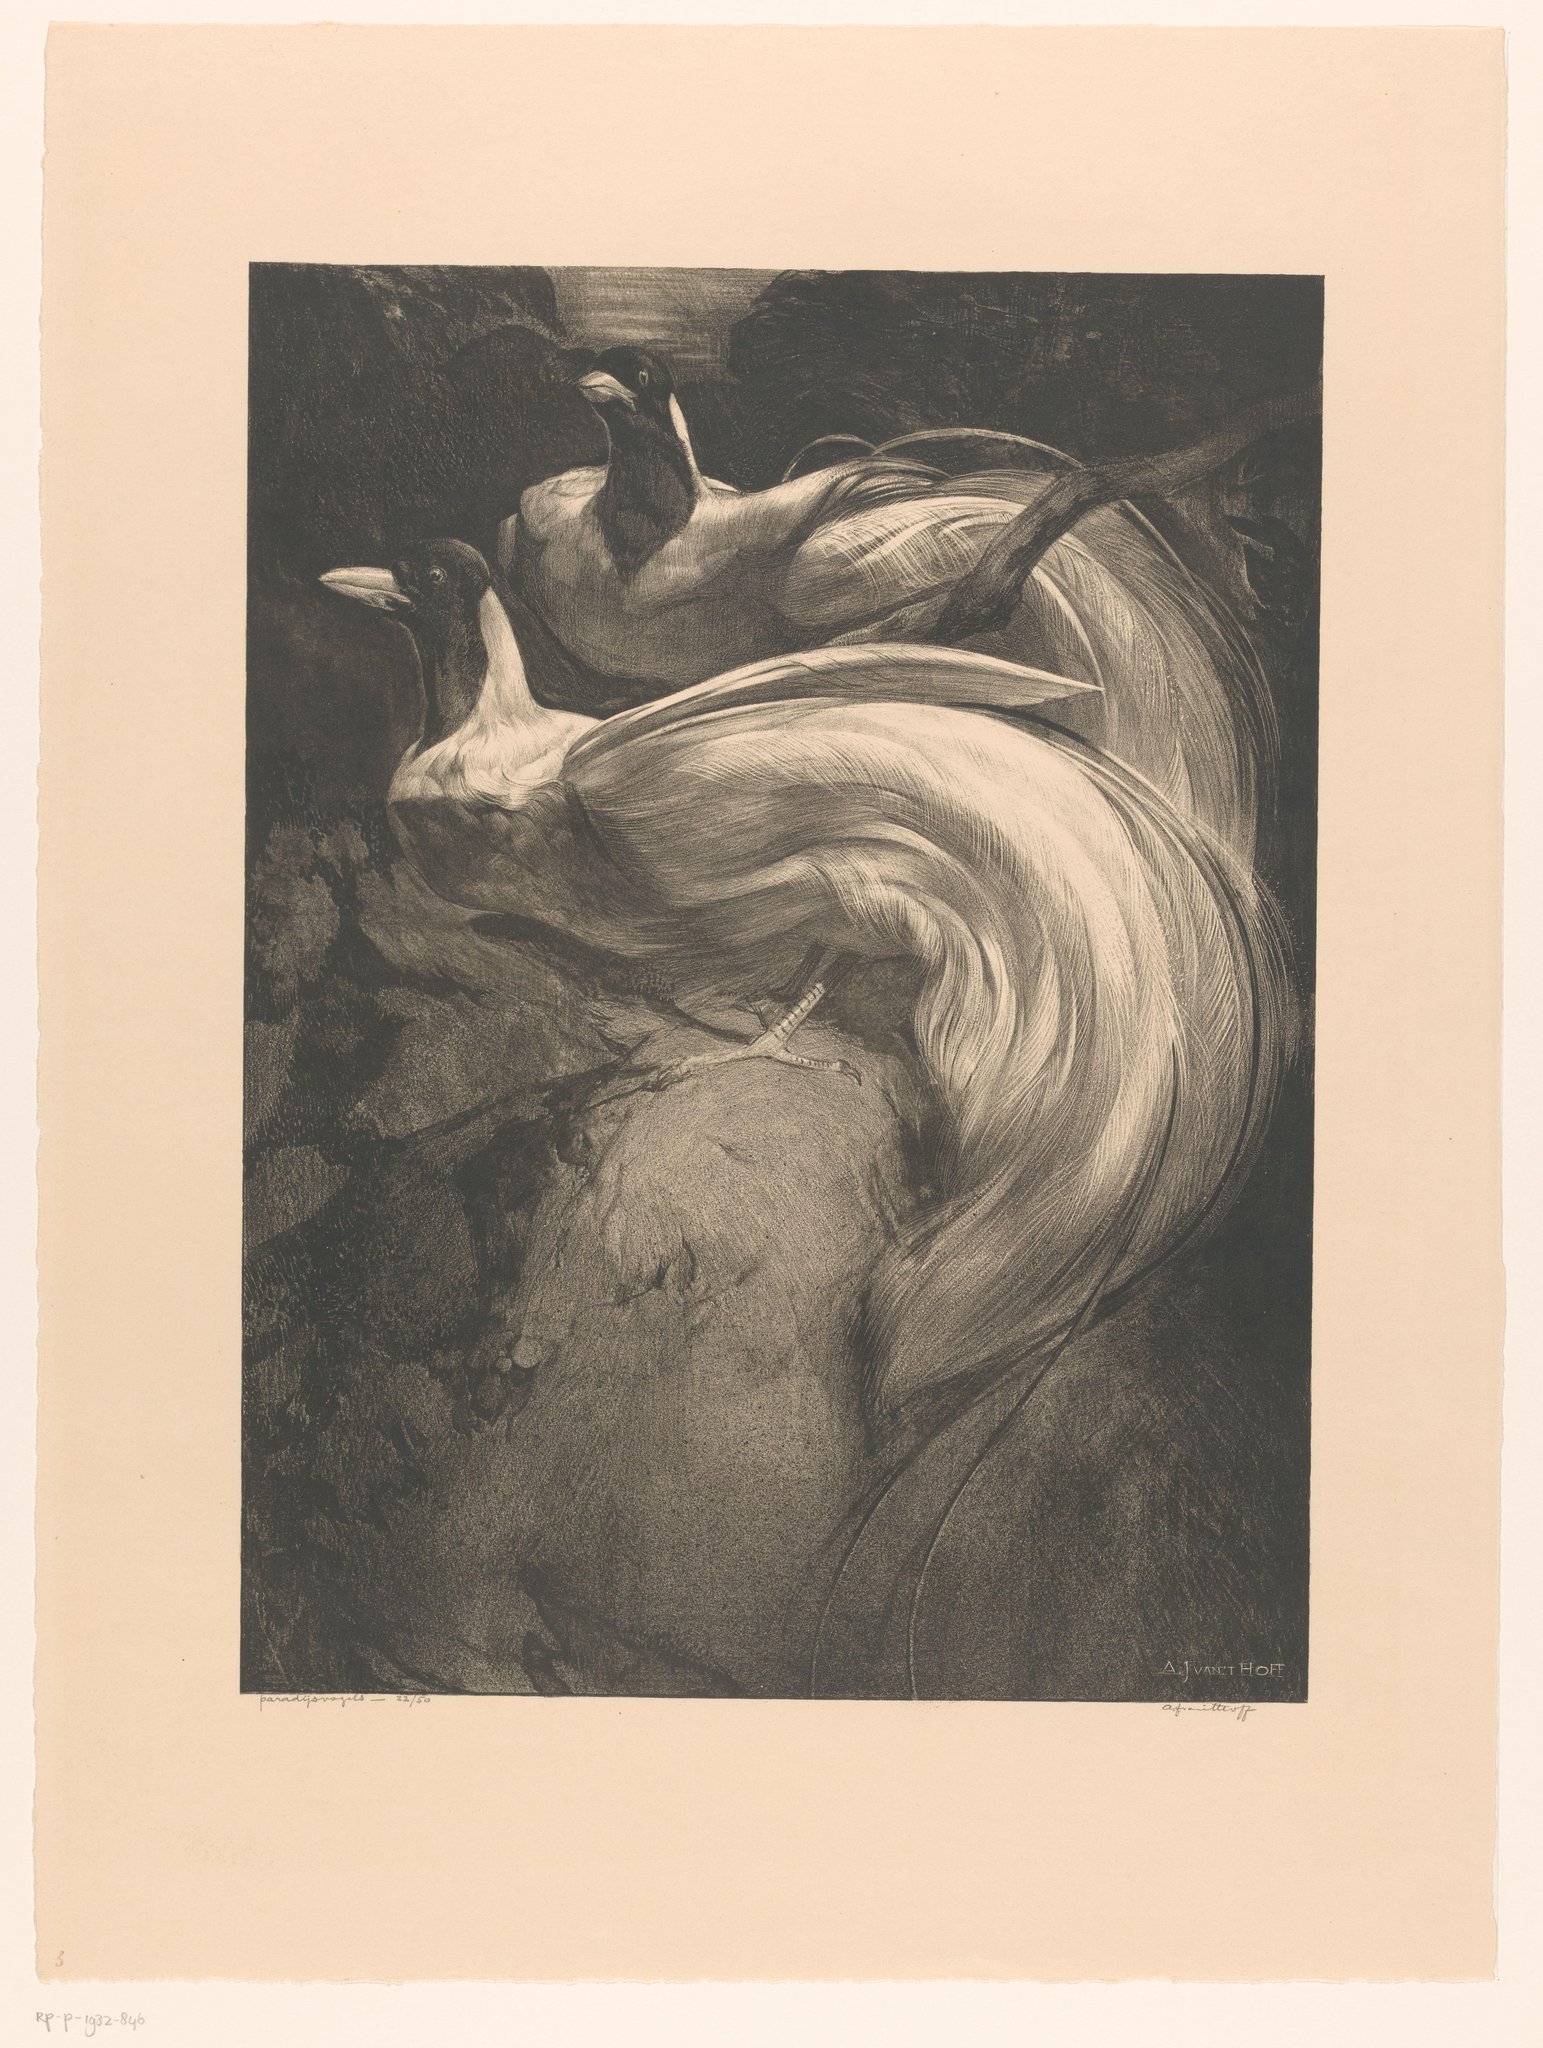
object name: print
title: Paradijsvogels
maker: adriaan j. van t hoff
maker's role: draughtsman, print maker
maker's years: 1893-1939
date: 1903-1932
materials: paper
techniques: lithograph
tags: fabulous animals ~ ornamental birds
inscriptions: collector's mark: Lugt 2228